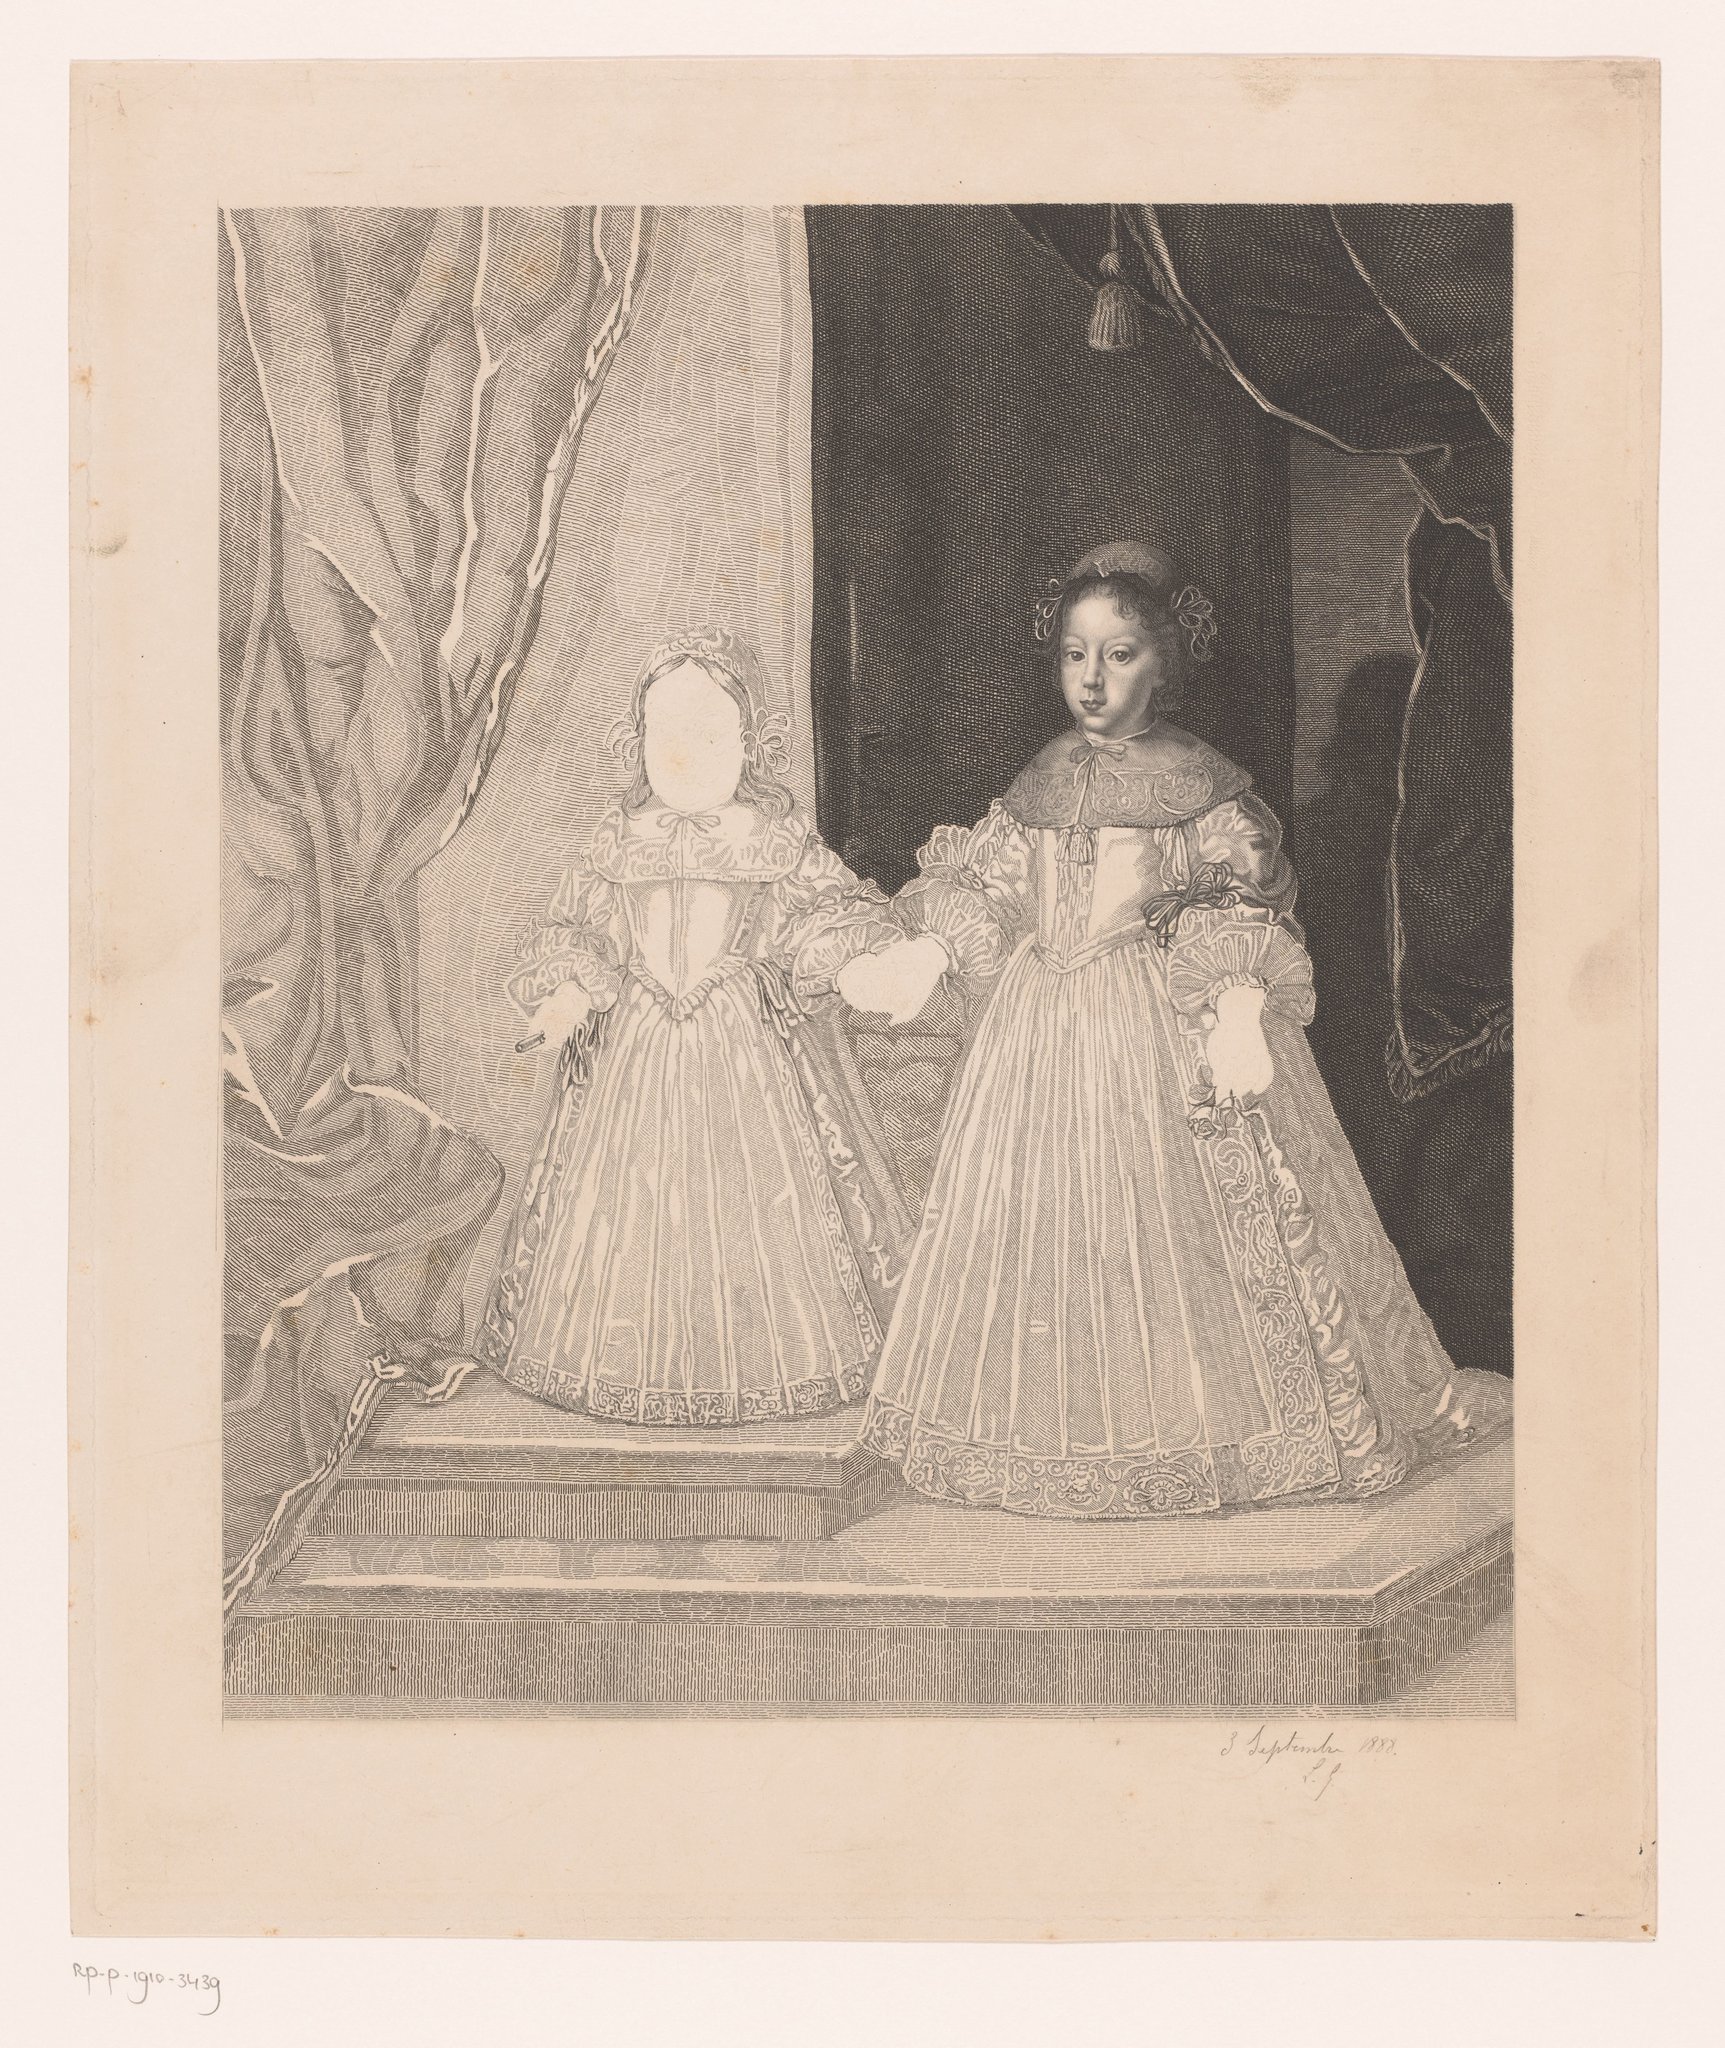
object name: print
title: Dubbelportret van twee onbekende kinderen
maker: louis joseph greuse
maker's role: print maker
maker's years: 1863-1950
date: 1888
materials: paper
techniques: engraving, etching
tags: child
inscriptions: collector's mark: Lugt 2228